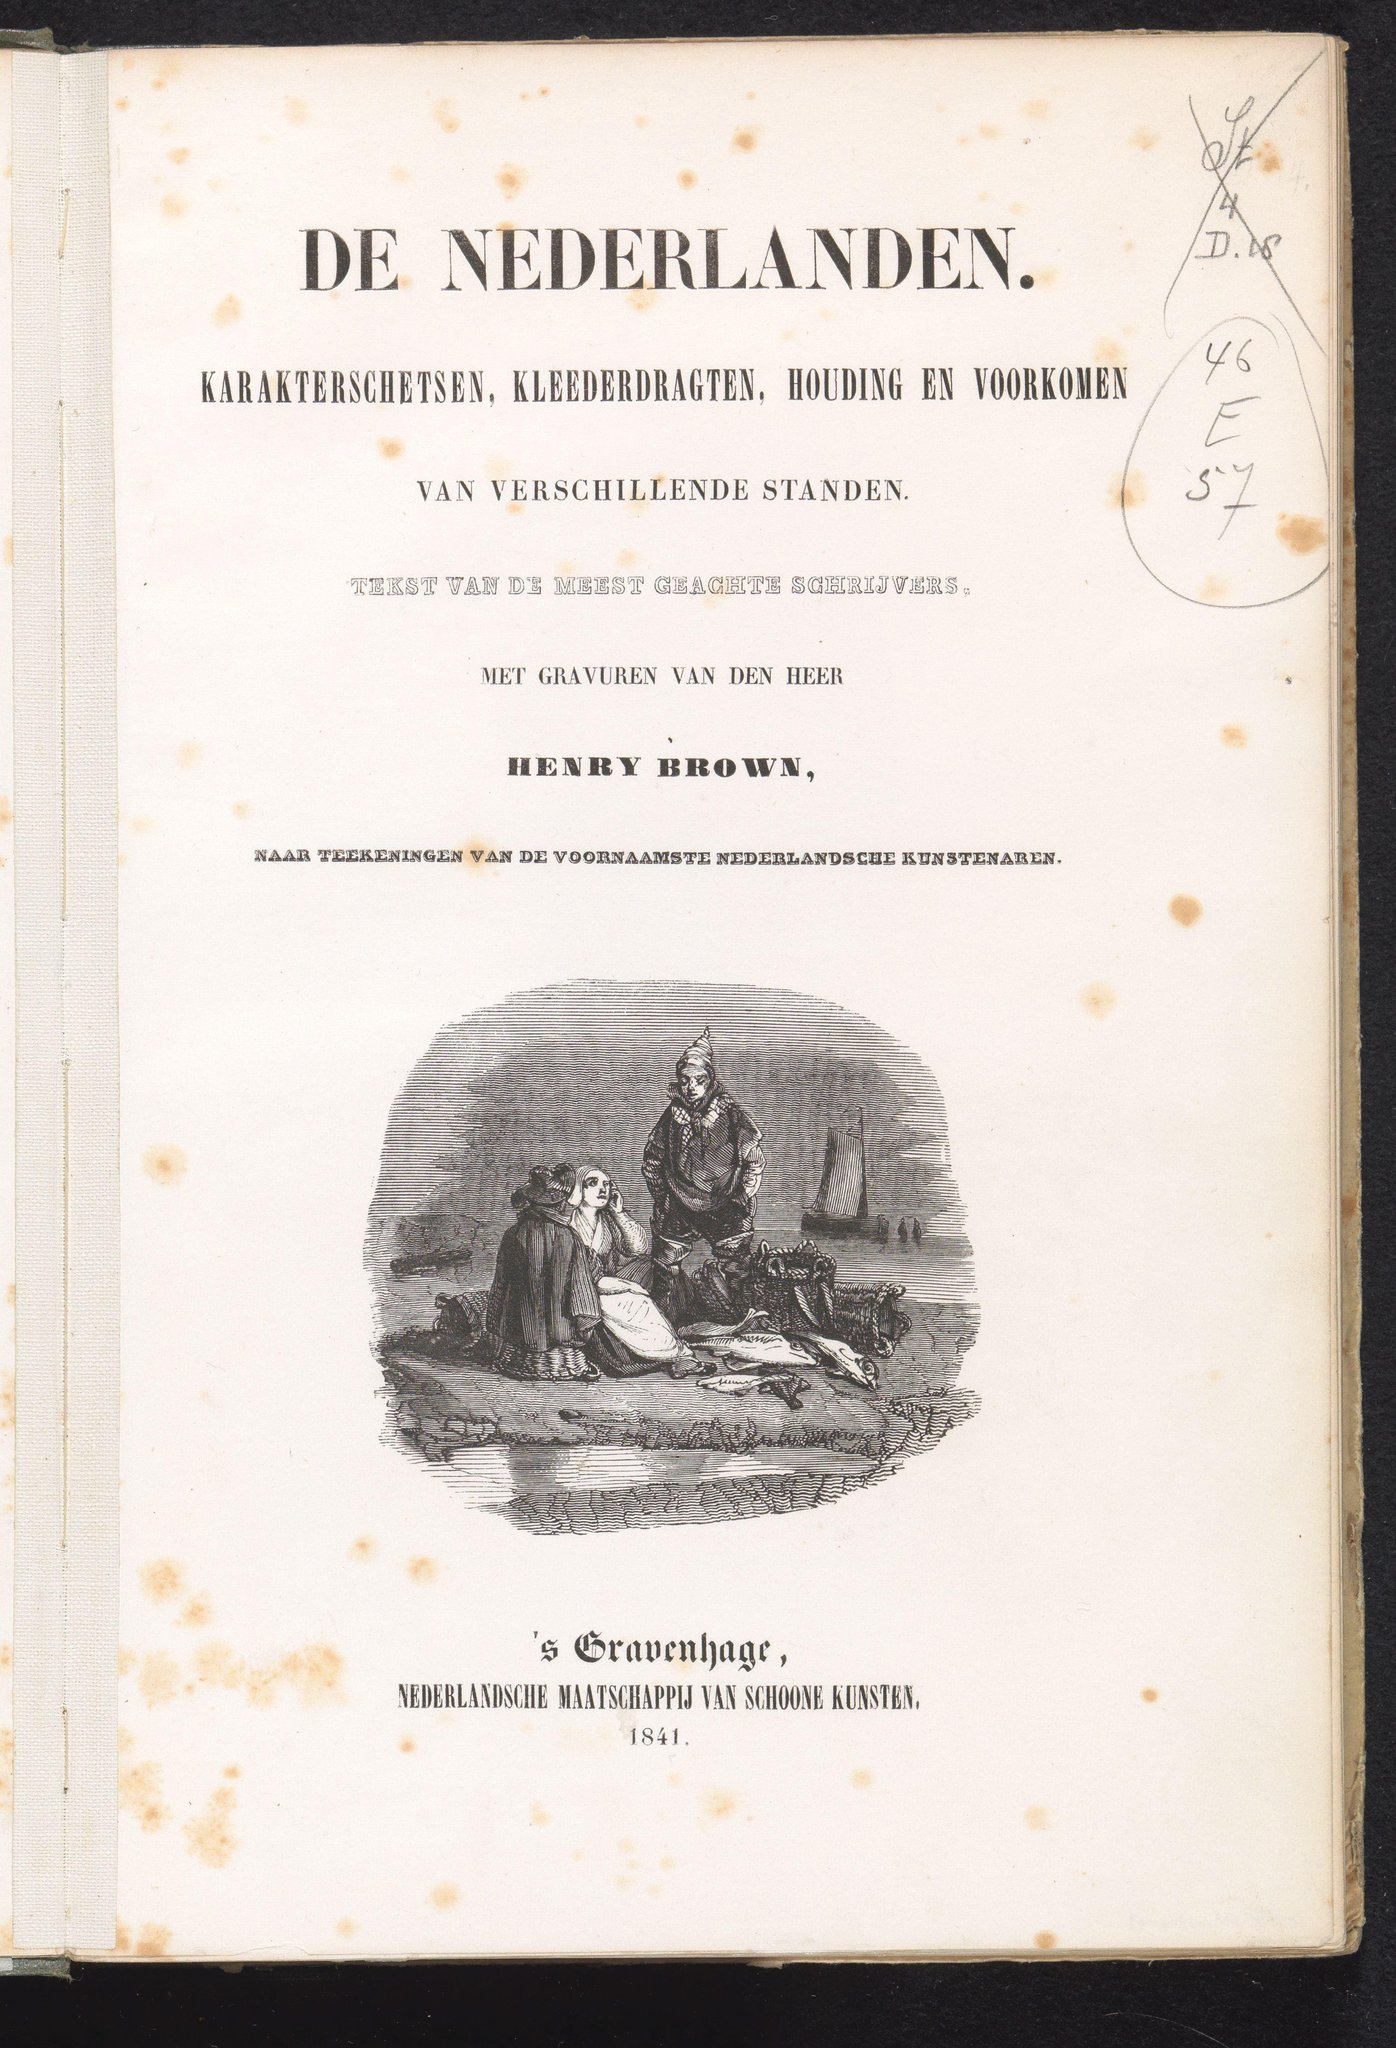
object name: print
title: Titelpagina voor: De Nederlanden : karakterschetsen, kleederdrachten, houding en voorkomen van verschillende standen : tekst van de meest geachte schrijvers : met gravuren van Henry Brown naar teekeningen van de voornaamste Nederlandsche kunstenaars, 1841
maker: henry brown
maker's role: print maker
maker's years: 1816-1870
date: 1841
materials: paper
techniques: letterpress printing, engraving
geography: netherlands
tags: netherlands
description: Vignet met vissersvrouwen met manden met vis. Titelpagina in het boek De Nederlanden: karakterschetsen, kleederdrachten, houding en voorkomen van verschillende standen, een boek met karakterschetsen, beroepen en klederdrachten van Nederlandse volkstypen uit 1841.